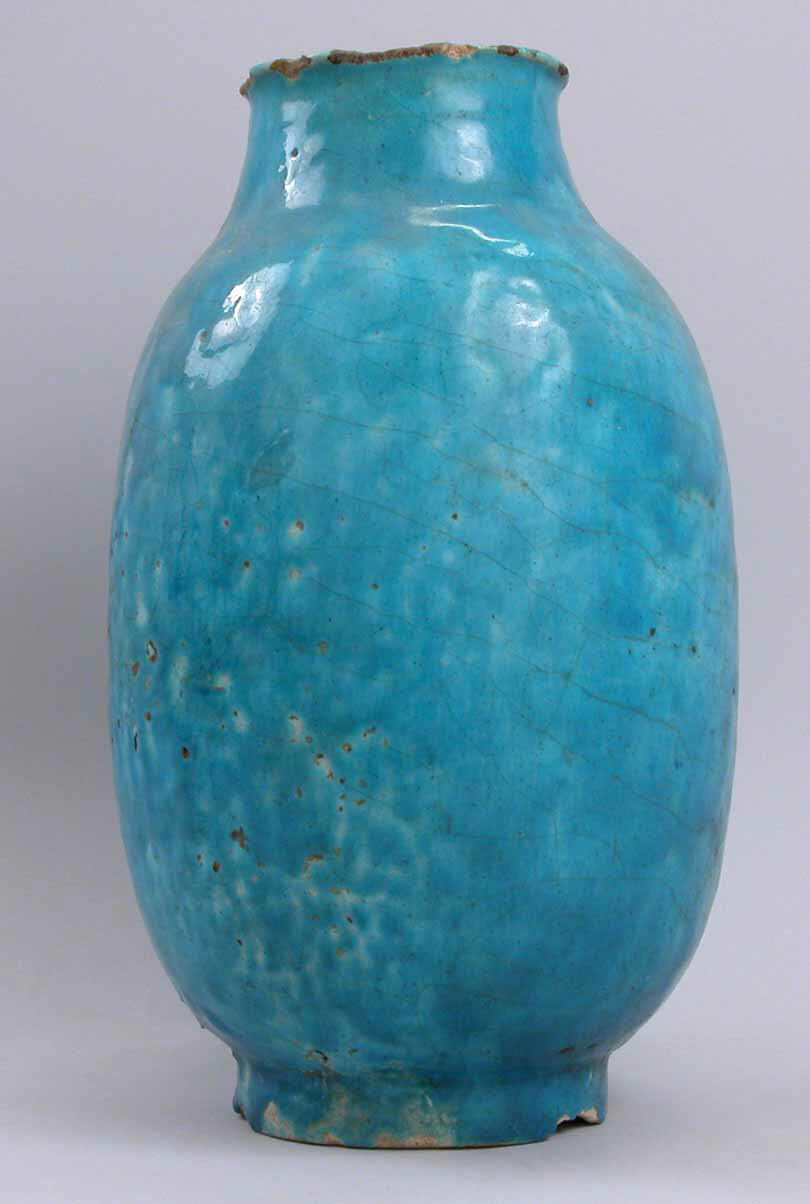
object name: jar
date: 1601-1700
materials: stonepaste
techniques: glazing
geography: iran